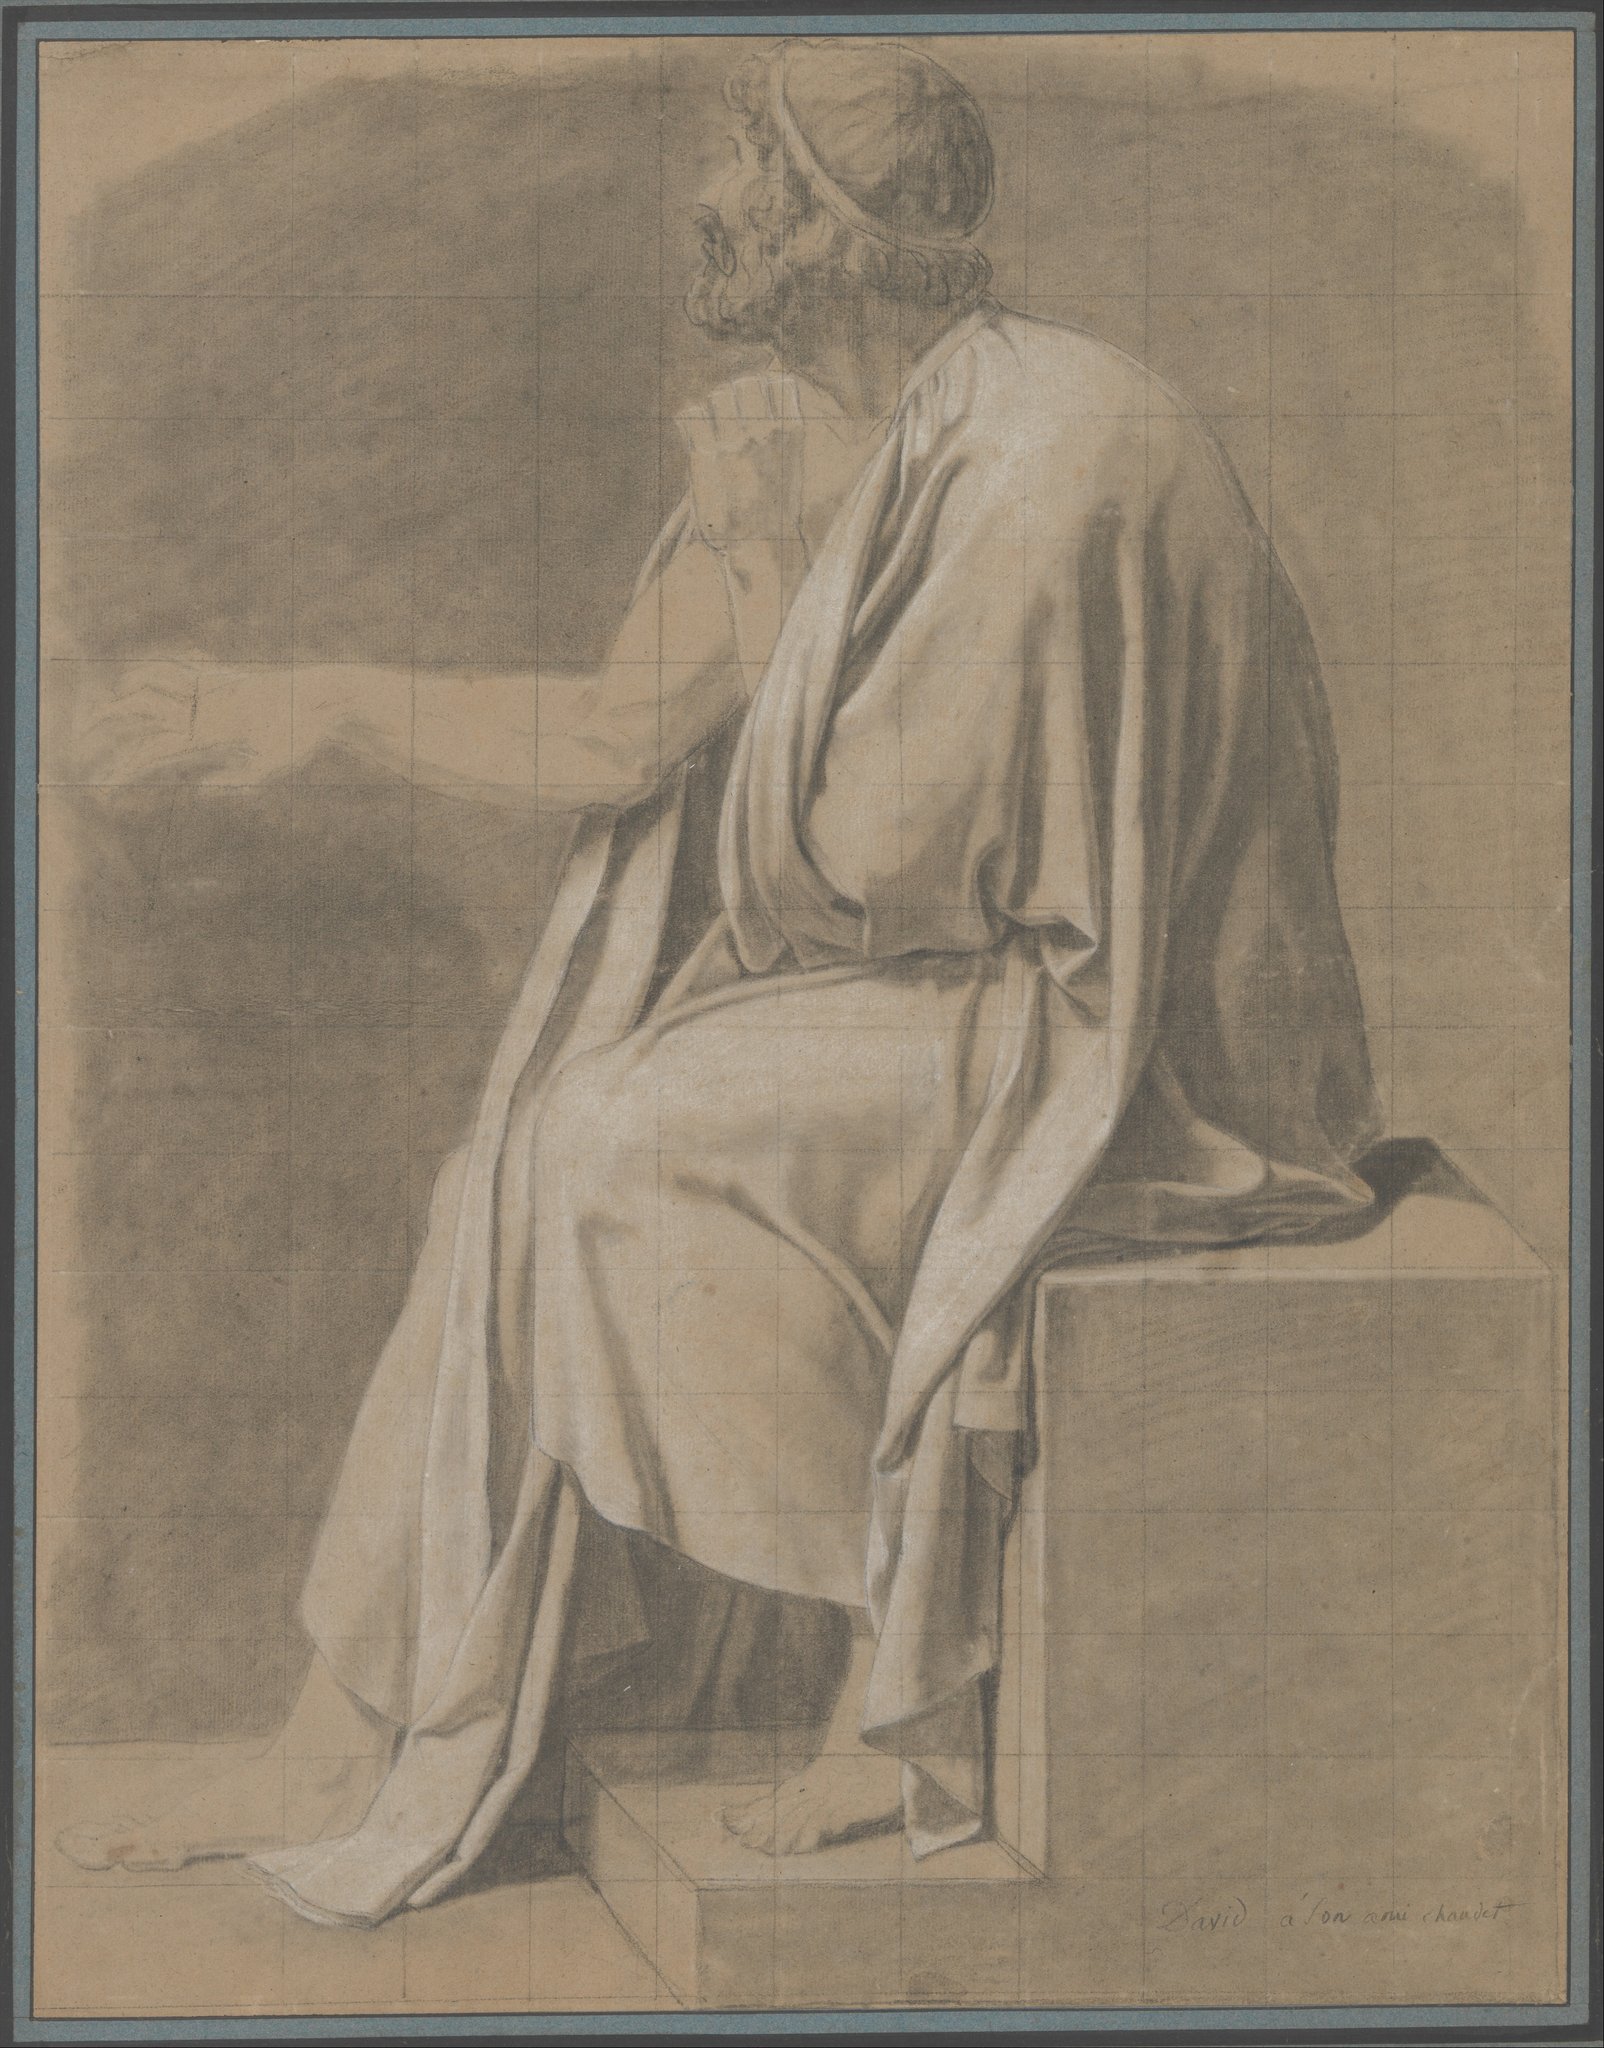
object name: drawing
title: Crito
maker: jacques louis david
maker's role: artist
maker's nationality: french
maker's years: 1748-1825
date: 1786-1787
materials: chalk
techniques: heightening, drawing, stumping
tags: men